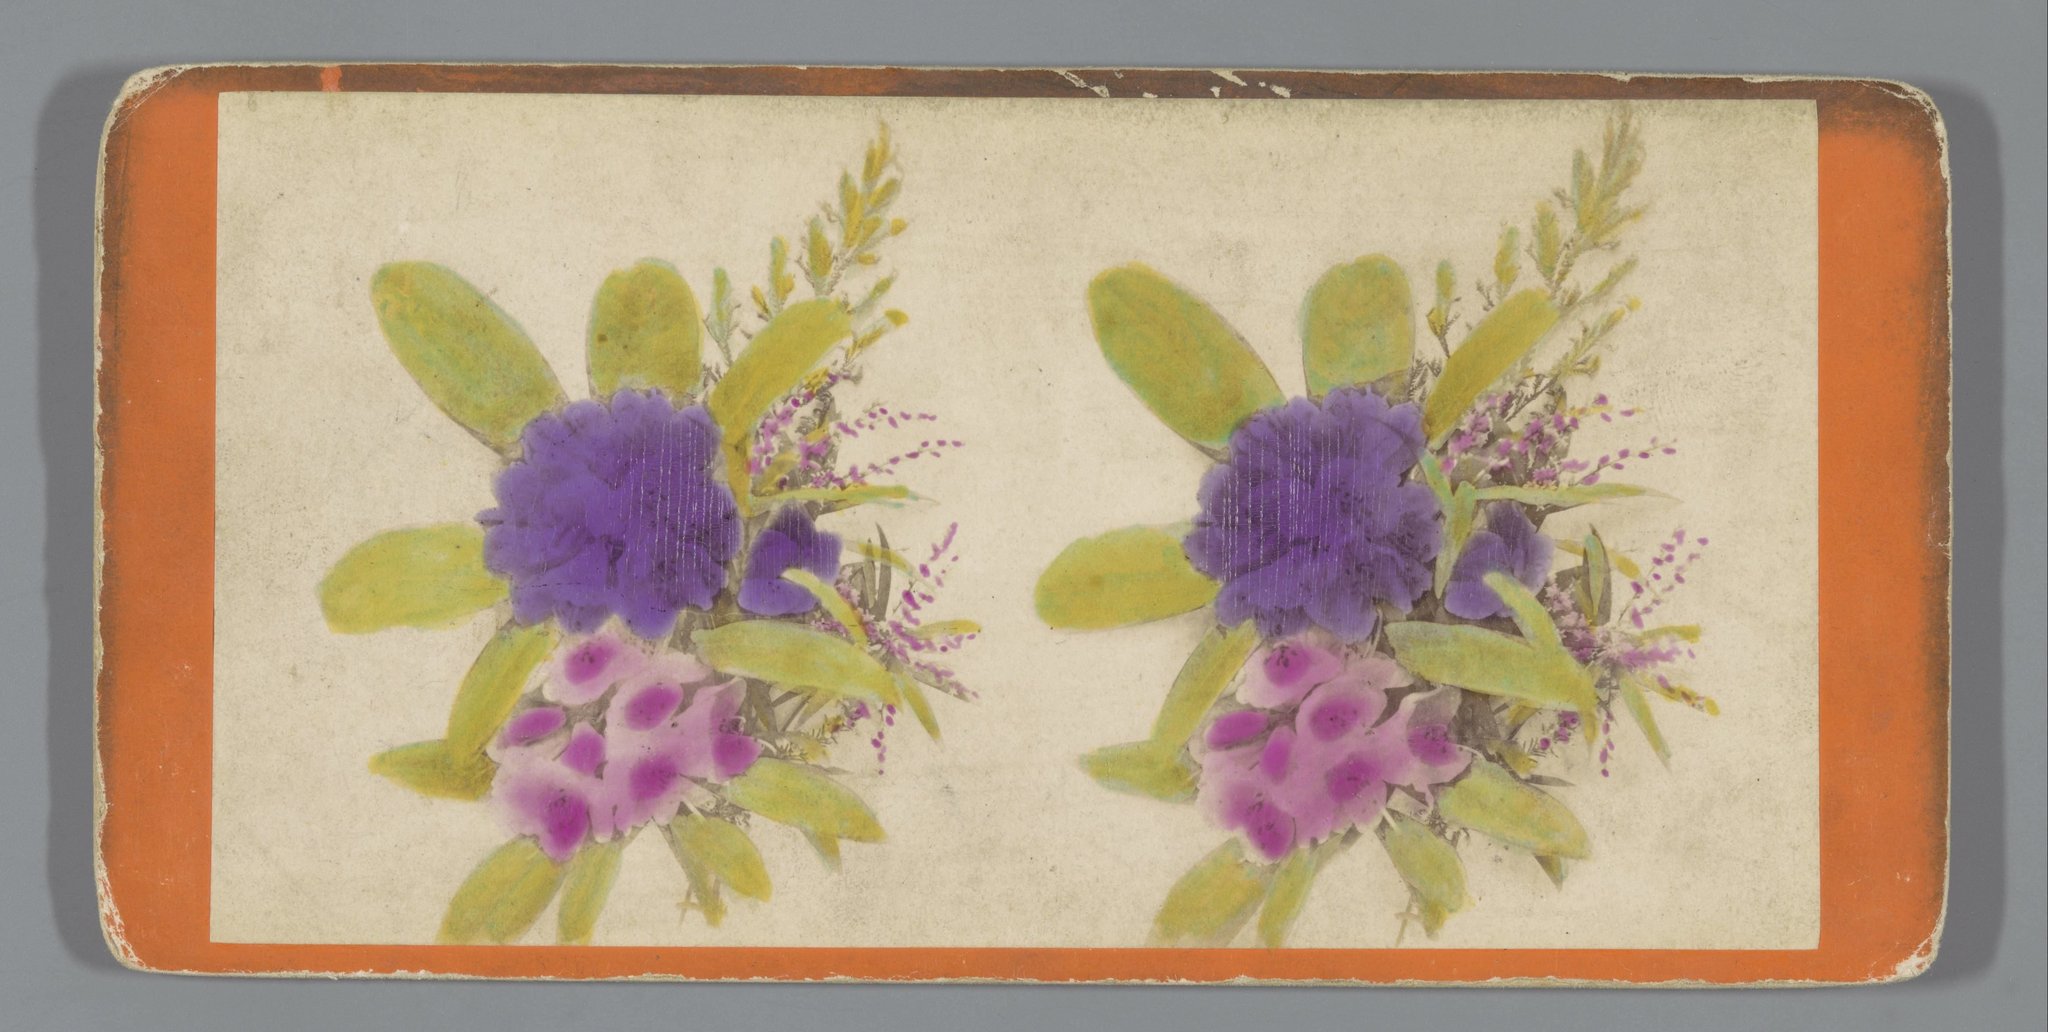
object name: stereograph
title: Stilleven met bloemen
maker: Anonymous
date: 1855-1870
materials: cardboard, photographic support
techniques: albumen print, hand coloring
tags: cut flowers; nosegay, bunch of flowers